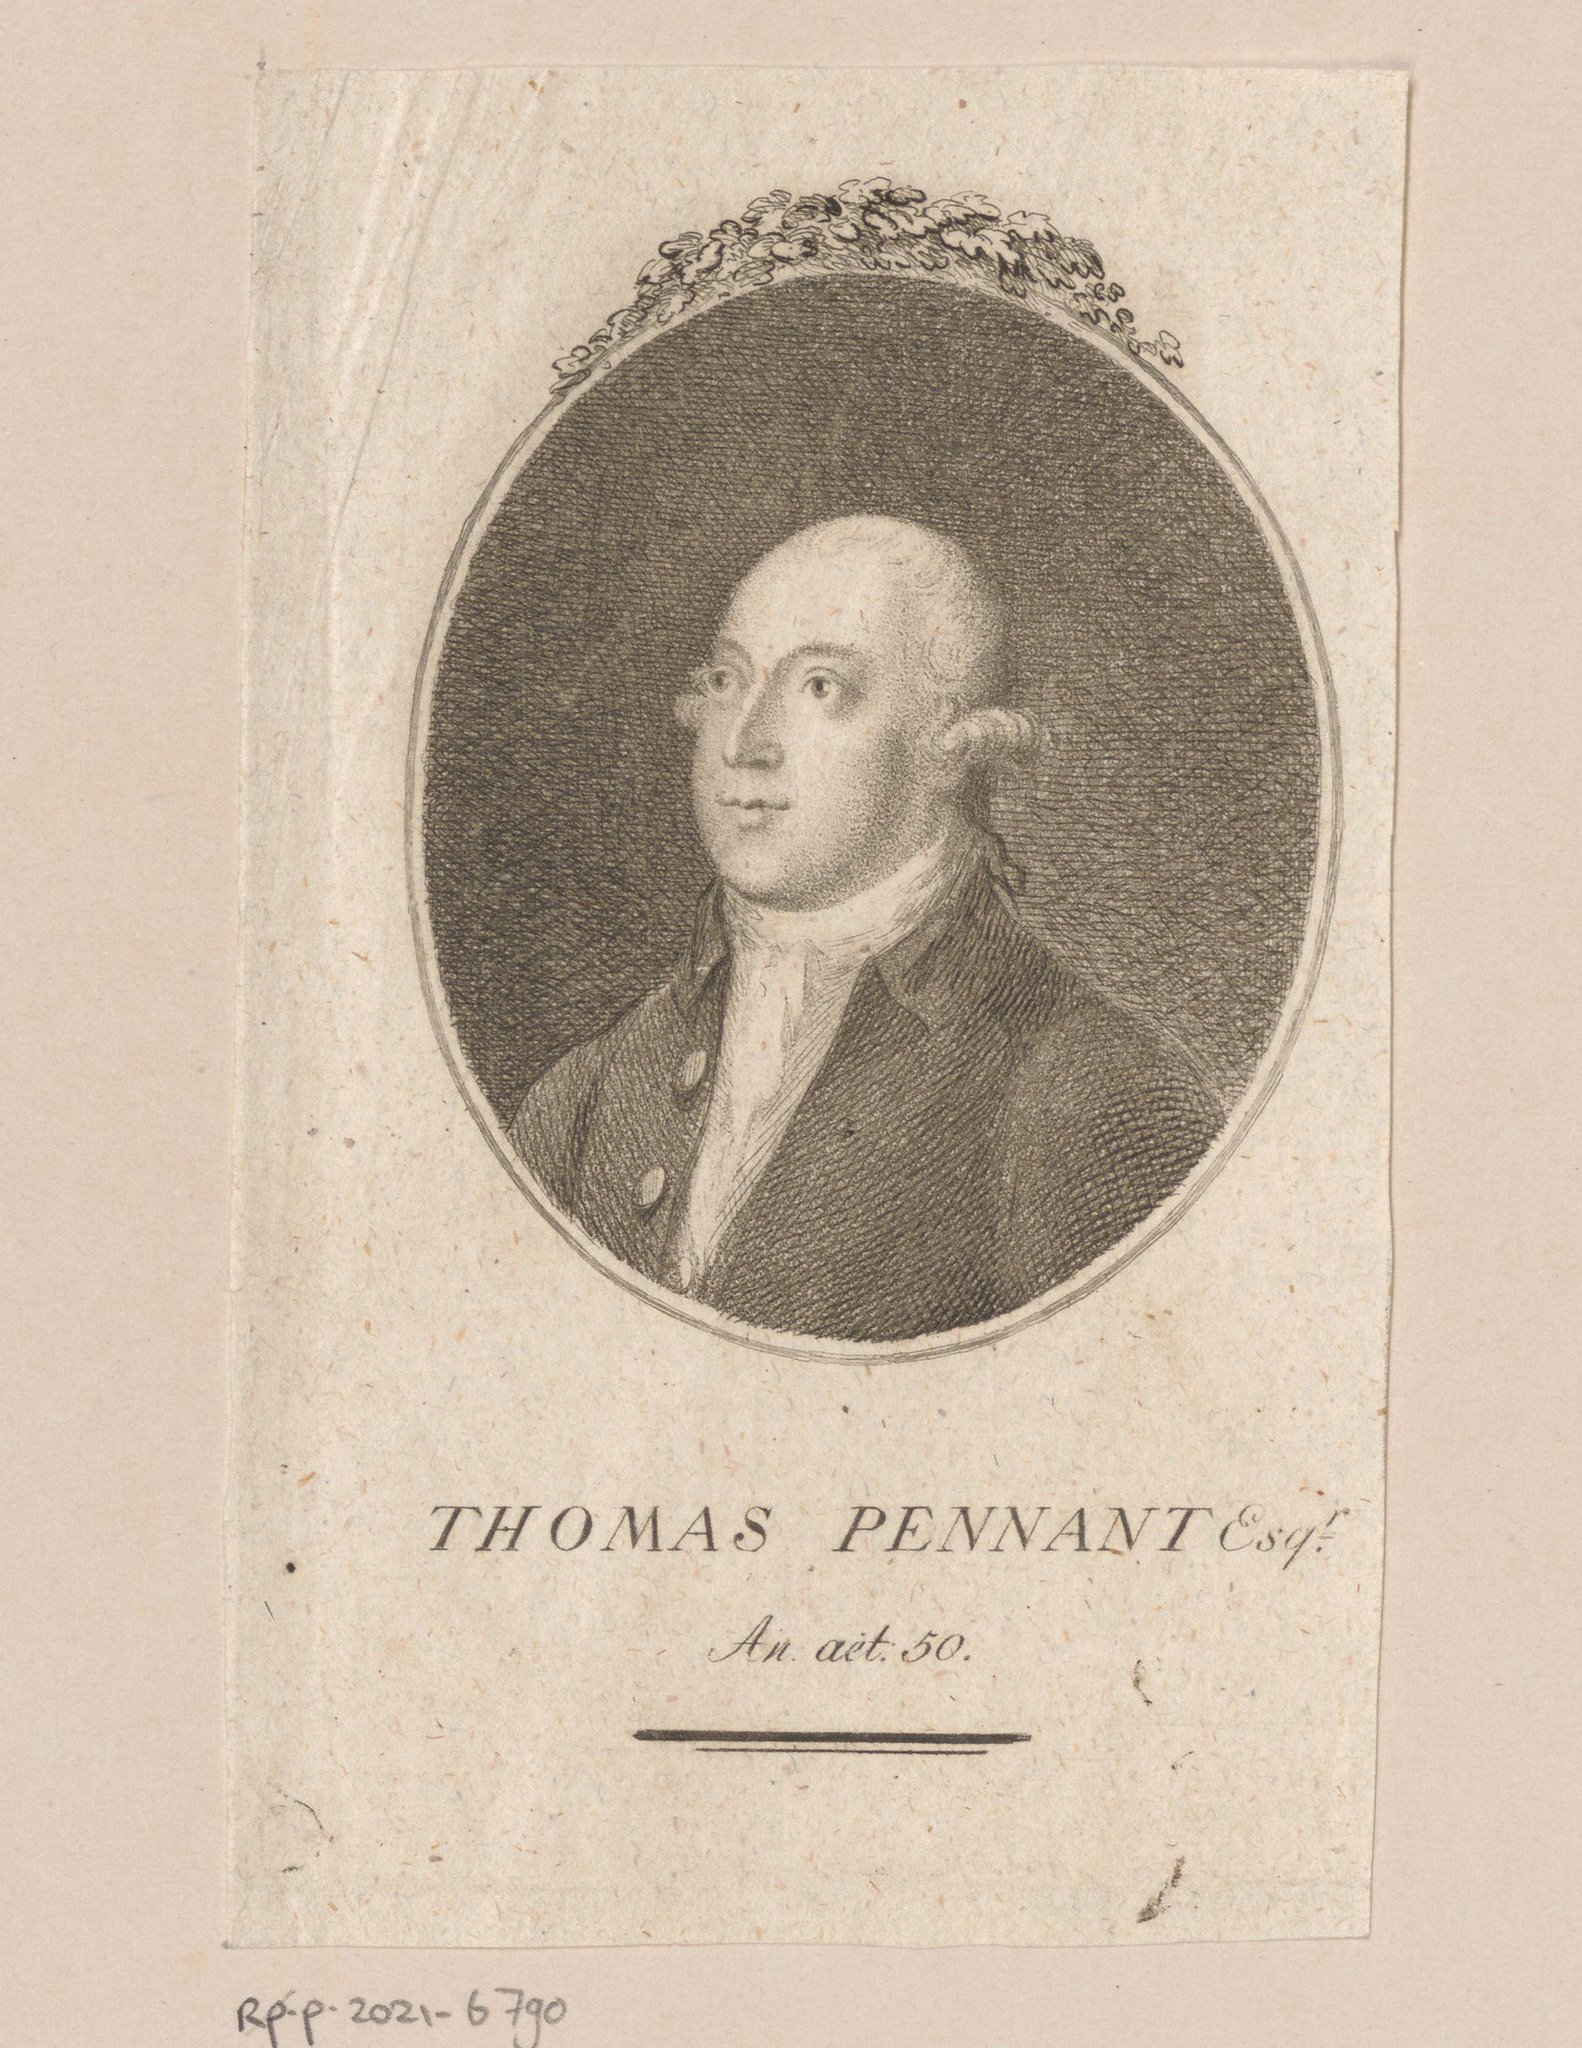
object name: print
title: Portret van Thomas Pennant op 50-jarige leeftijd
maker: Anonymous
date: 1756-1799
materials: paper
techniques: aquatint, etching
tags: adult man, historical persons